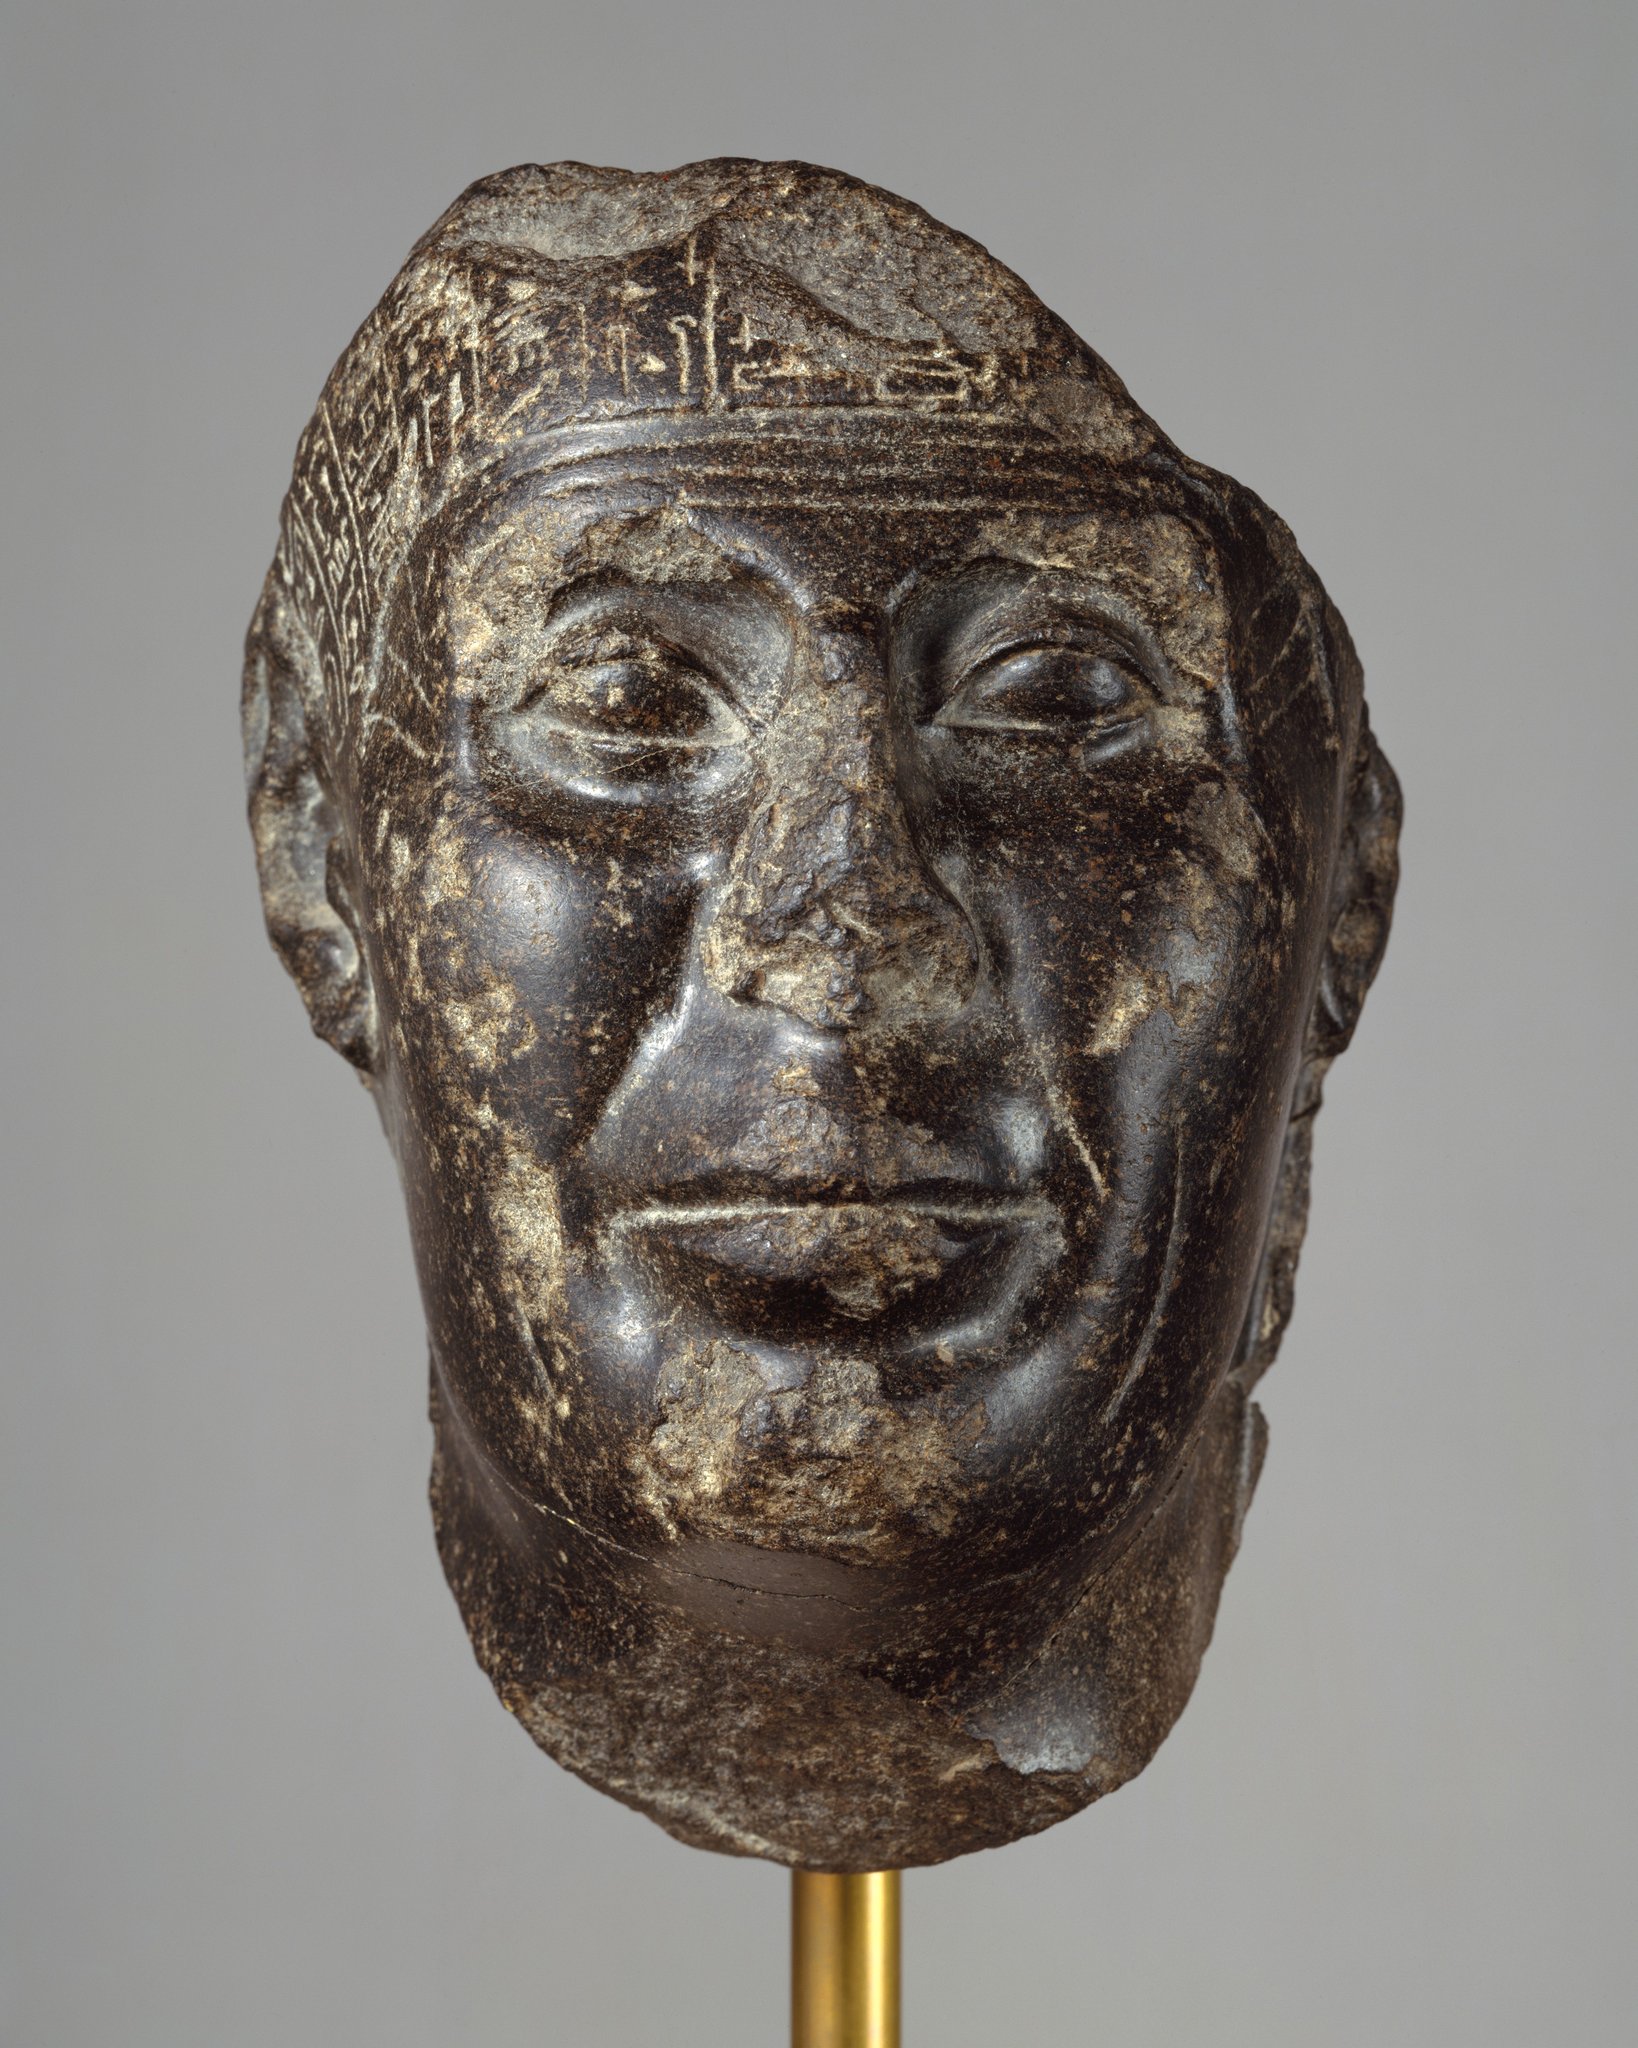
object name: head, priest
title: Head from a Statue with Magical Texts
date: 360-343 BCE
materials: stone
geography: egypt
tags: men